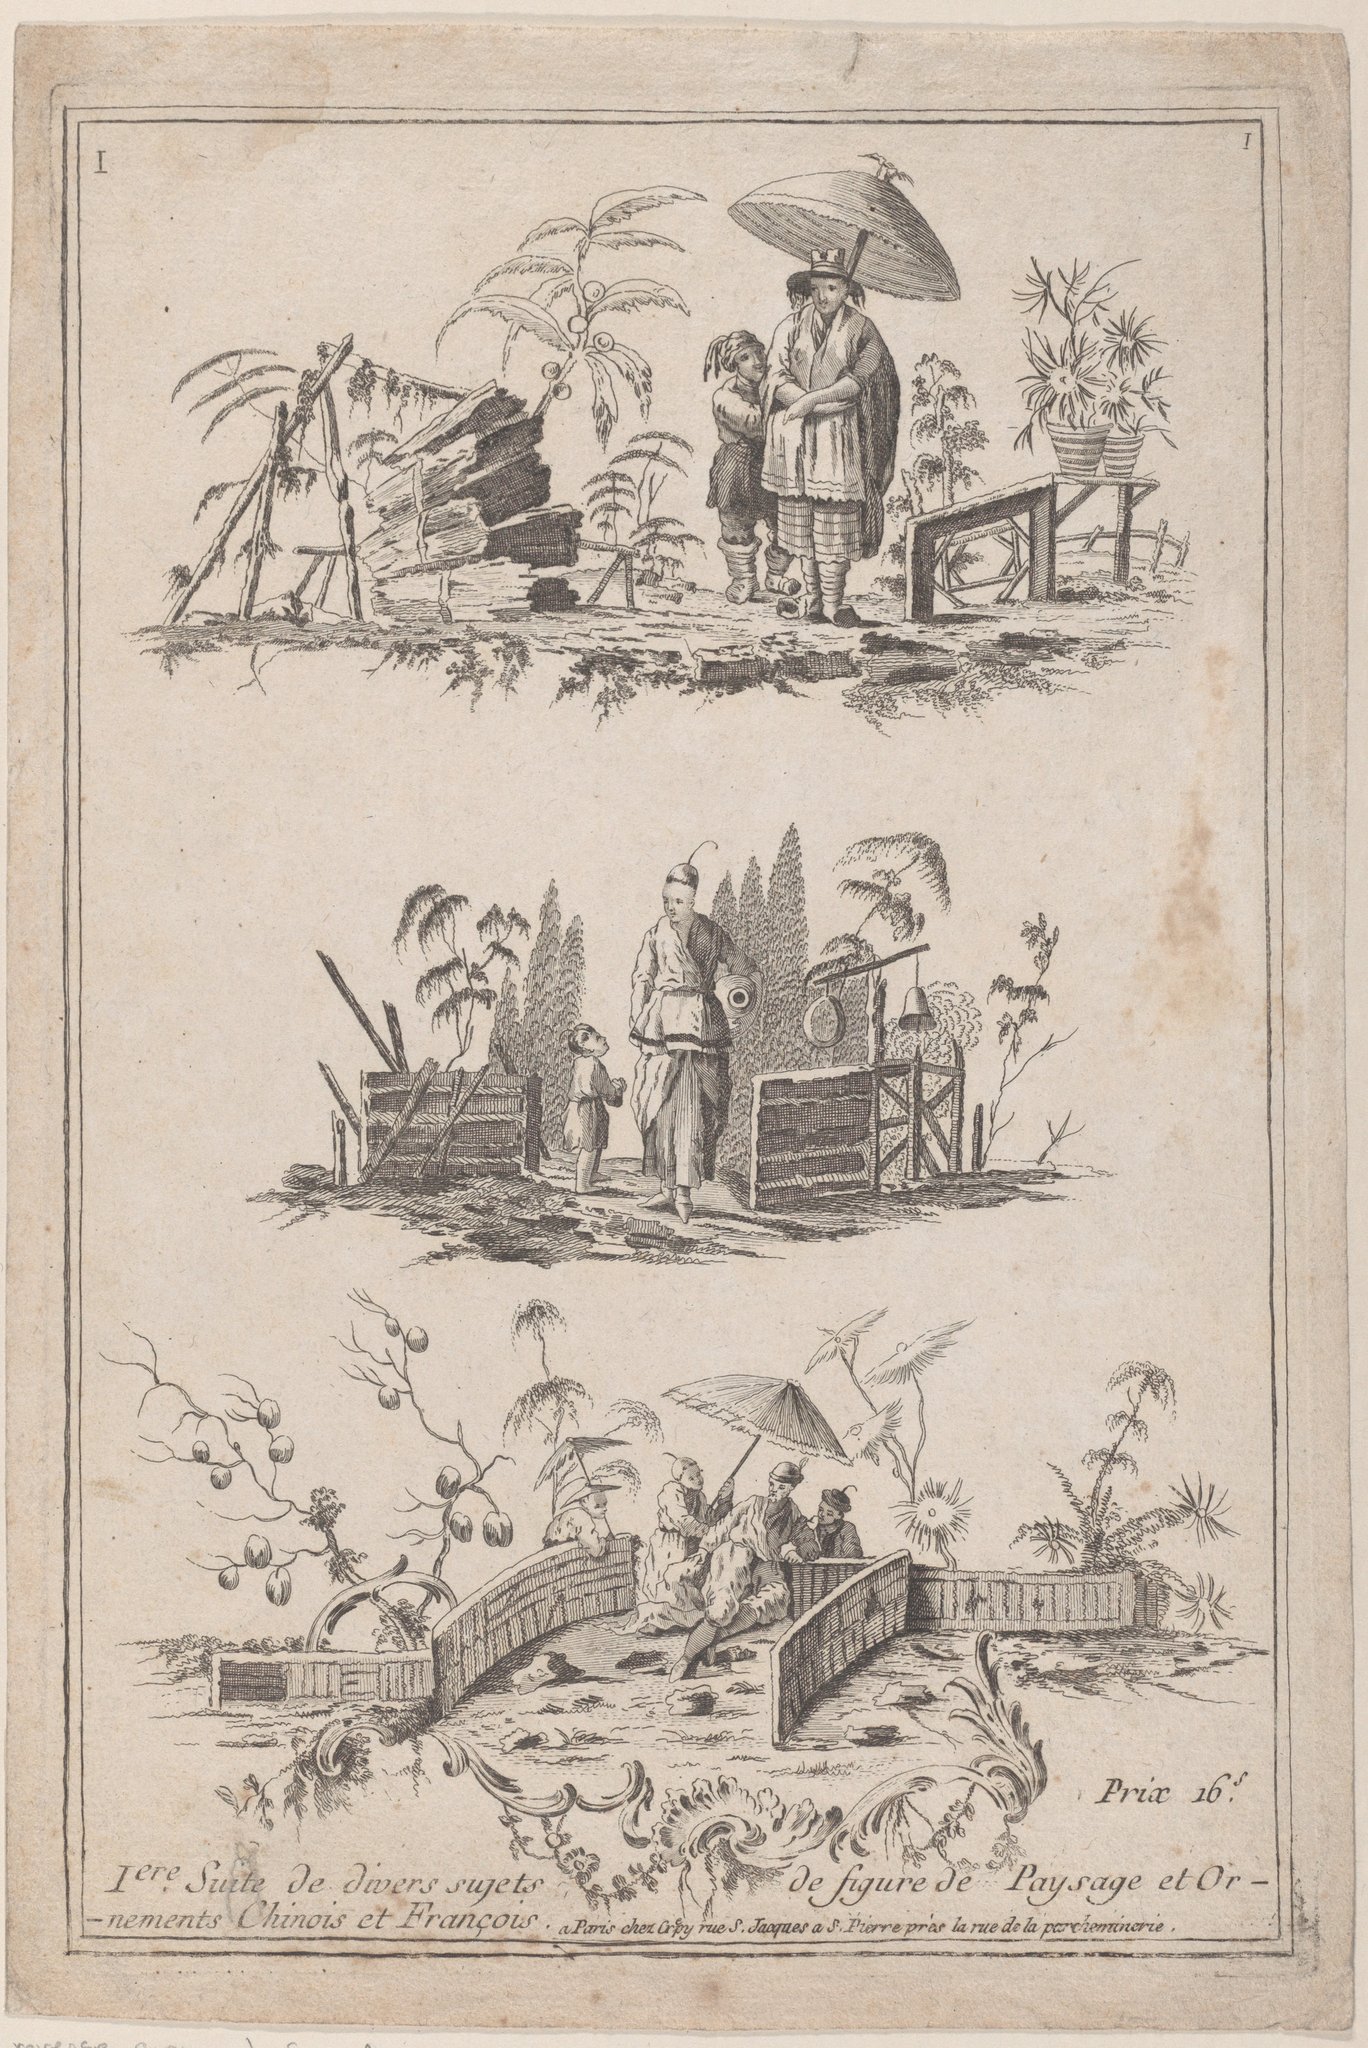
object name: print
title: Suite de divers sujets de figure de Paysage et Ornements Chinois et François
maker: jean pillement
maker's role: artist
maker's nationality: french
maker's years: 1728-1808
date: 1770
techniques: etching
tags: chinoiserie